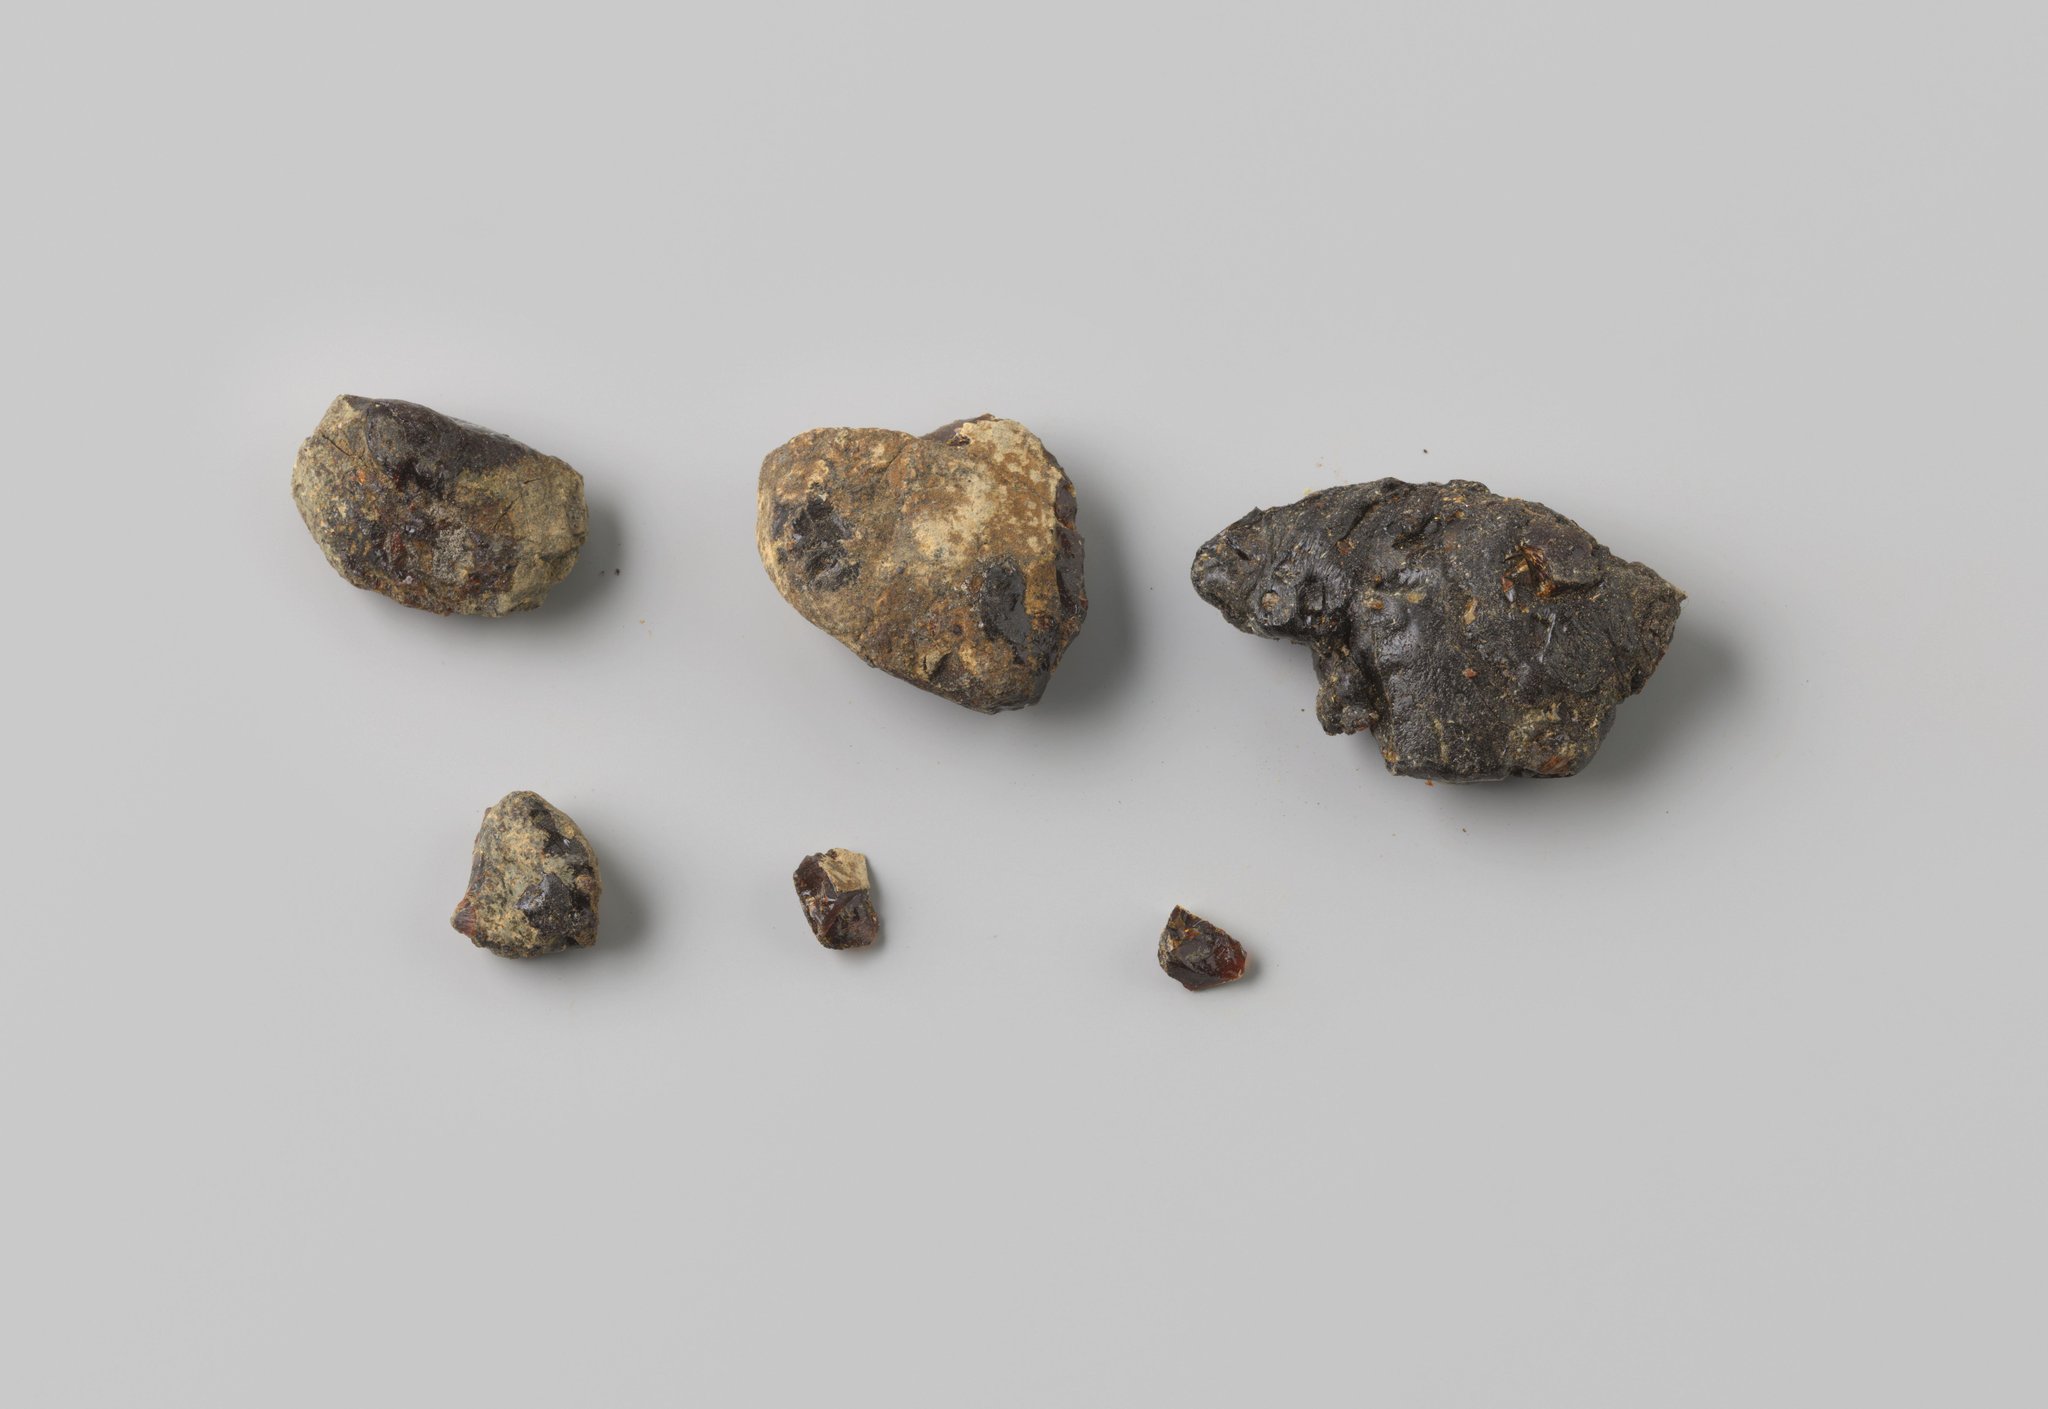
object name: tar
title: Brokken pek/ teer uit het wrak van de Oost-Indiëvaarder Hollandia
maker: niet van toepassing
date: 1700-1743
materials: pitch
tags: verenigde oostindische compagnie, hollandia (schip), annet